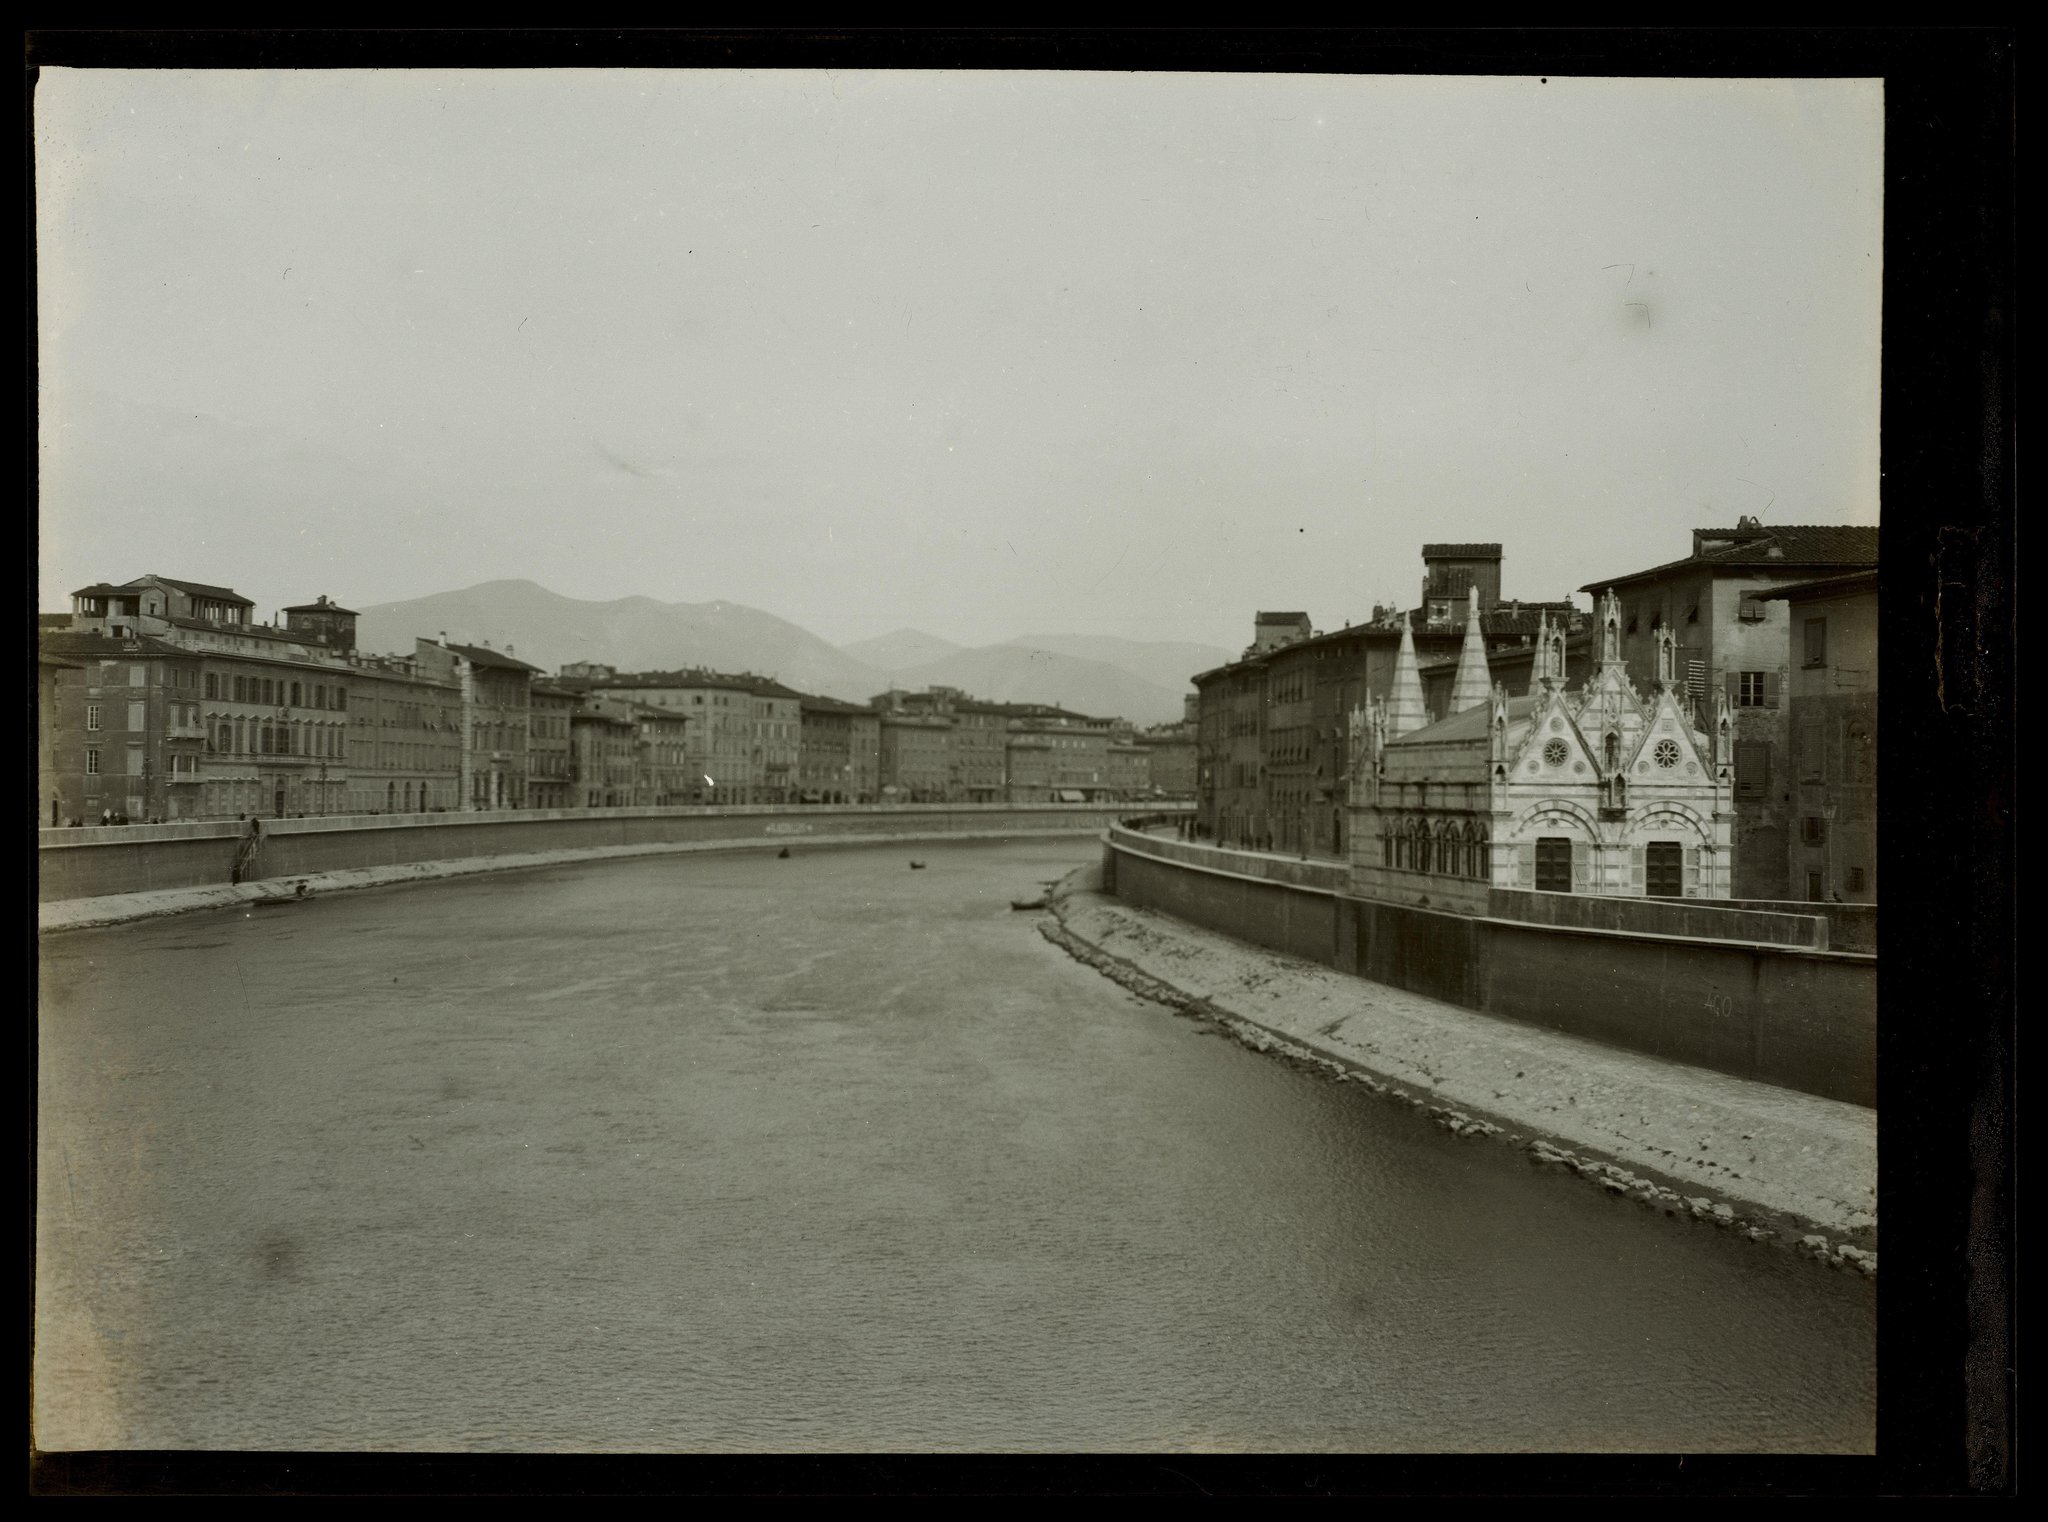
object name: photograph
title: Filmnegatief met opname van Genua, Pisa, Ravenna of Milaan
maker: Anonymous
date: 1907-1935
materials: film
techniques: gelatin silver negative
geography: italy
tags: italy